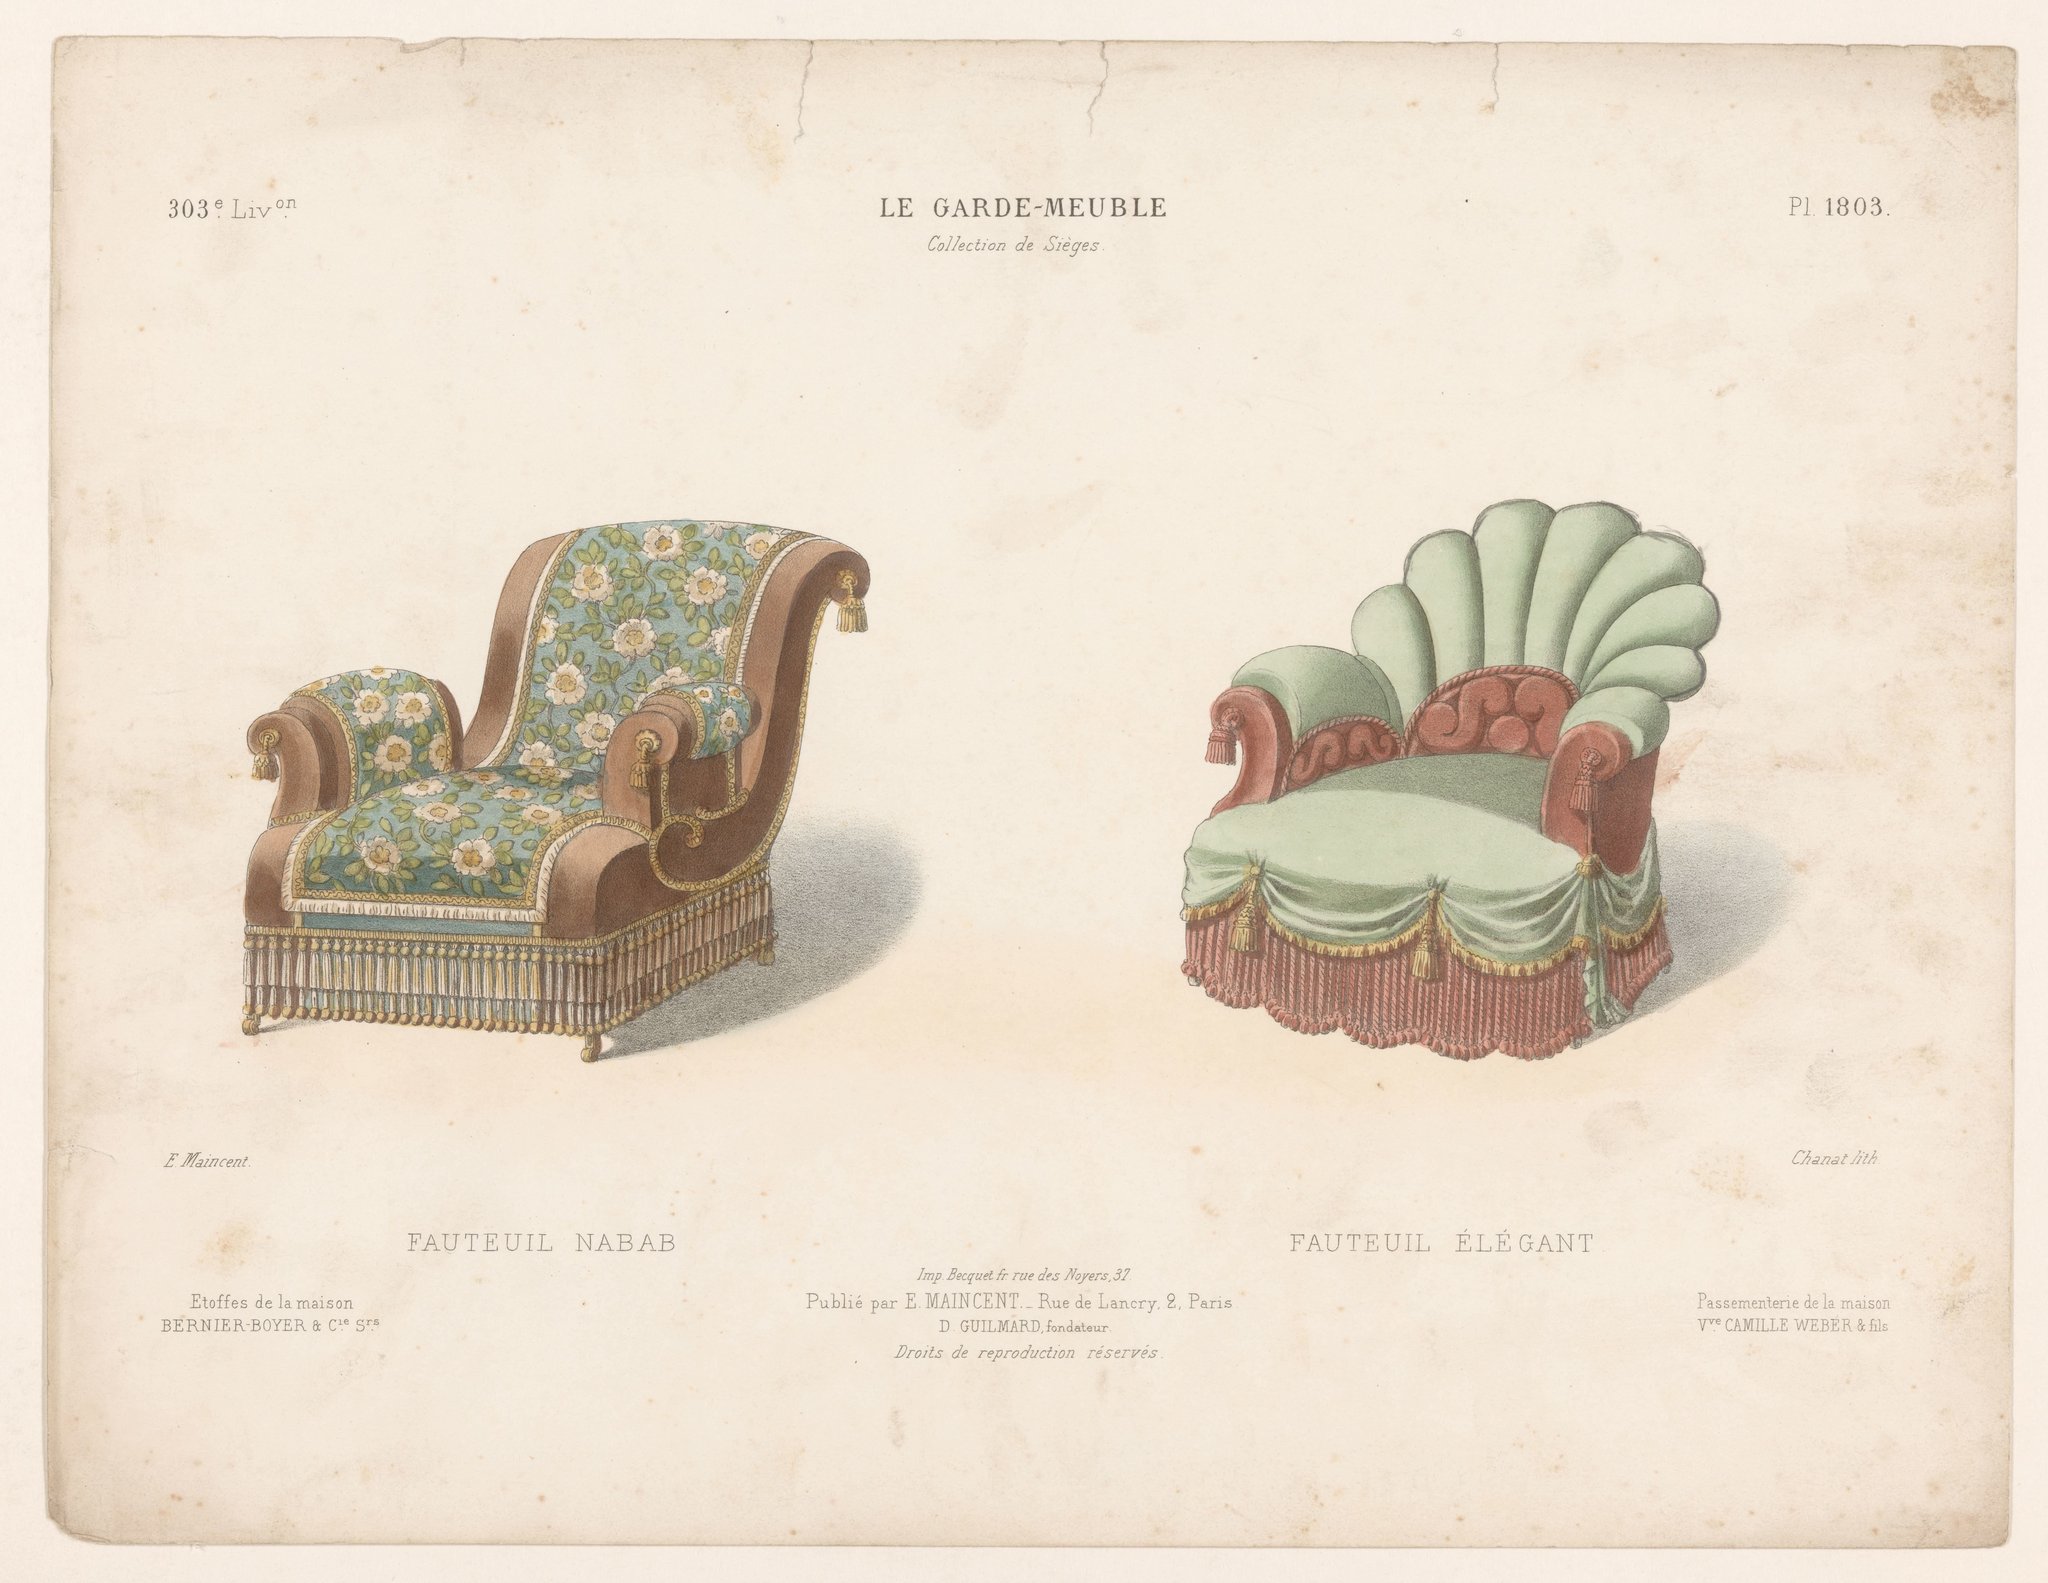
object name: print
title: Le garde-meuble / Collection de Sièges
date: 1885-1895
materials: paper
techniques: hand coloring, lithograph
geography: paris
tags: seating furniture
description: Ieder Livraison in de serie Le Garde-Meuble bevat negen platen: drie 'sièges' (zitmeubels), drie 'meubles' (diverse meubels zoals tafels en kasten) en drie 'tentures' (gordijnen en draperieën).